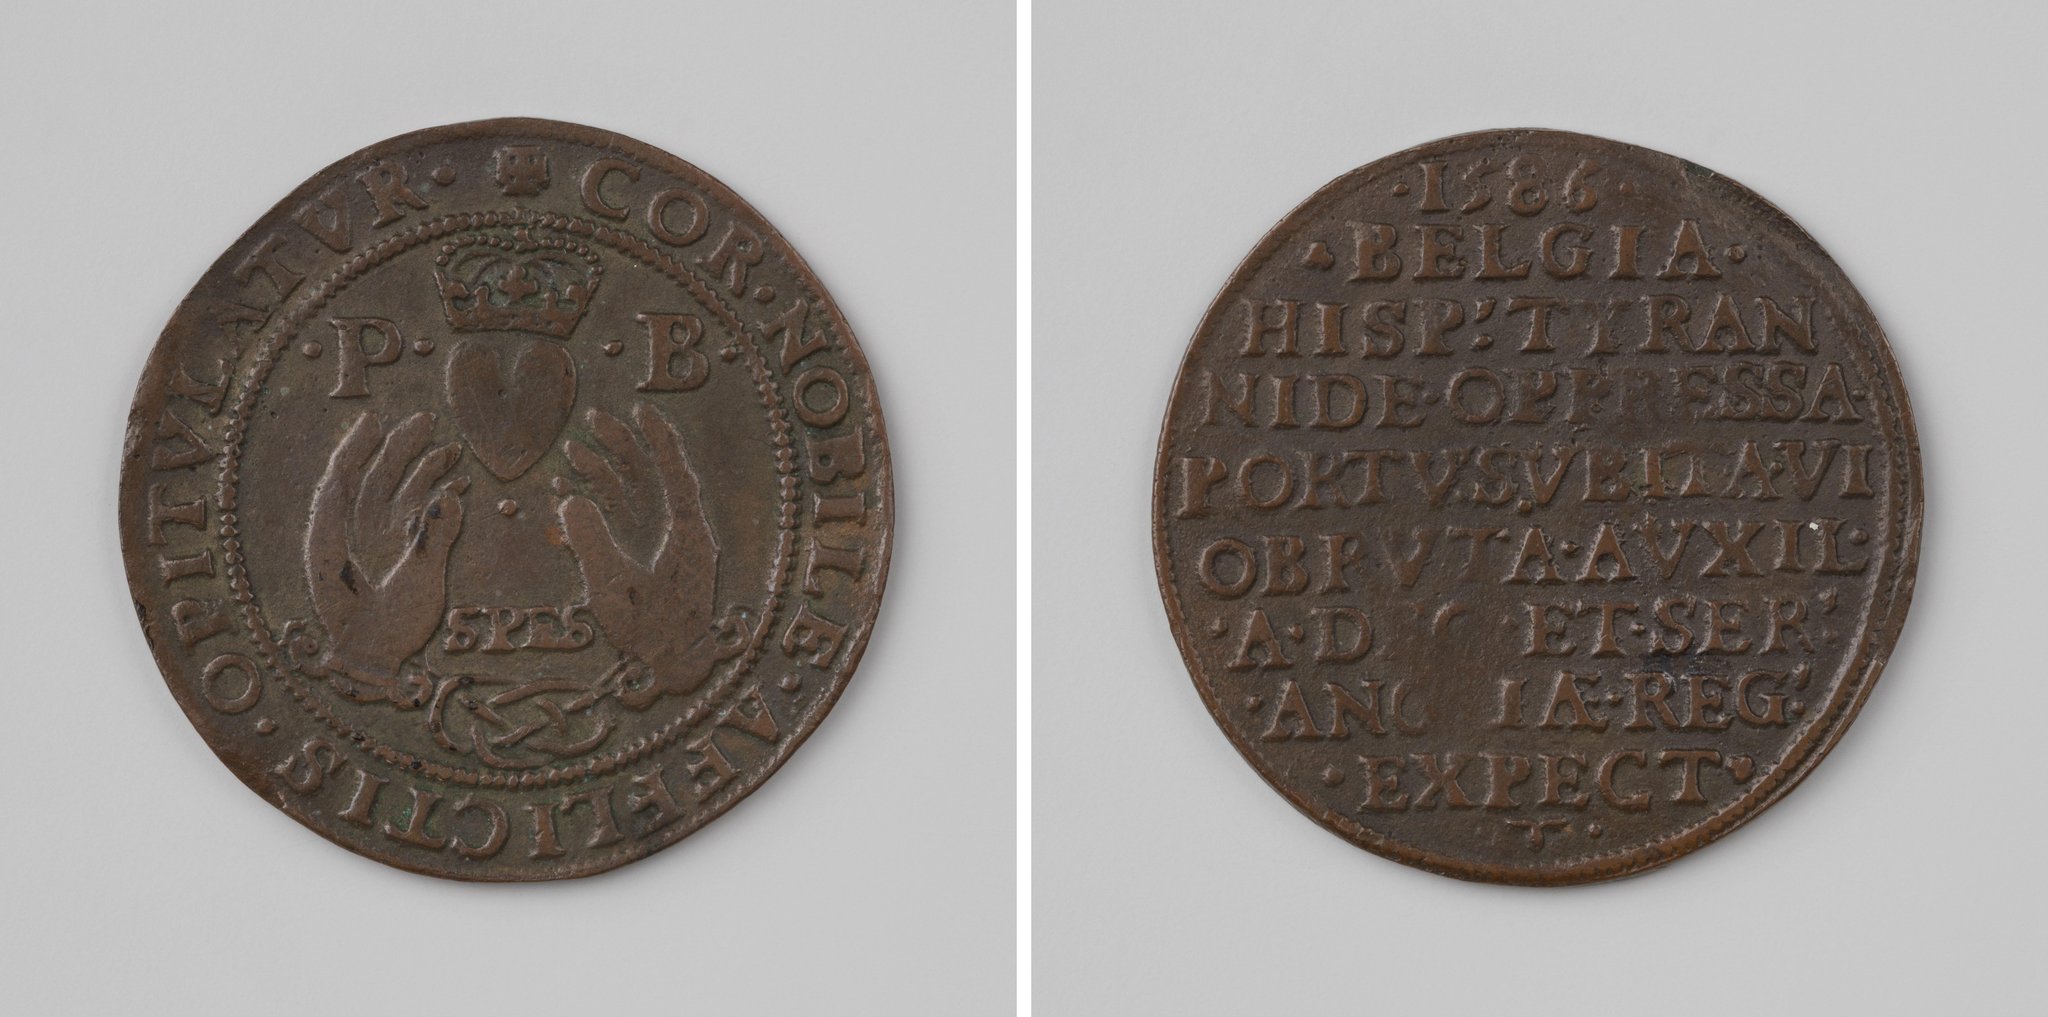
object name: jeton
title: Engelse hulp aan de opstandelingen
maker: Anonymous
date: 1586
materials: copper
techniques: striking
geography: harderwijk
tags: greenwich, koningin, elizabeth i tudor (koningin van engeland), tachtigjarige oorlog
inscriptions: circumscription: ‘COR NOBILE AFFLICTIS OPITVLATVR / P B SPES’, inscription: ‘1586 BELGIA HISP TYRANNIDE OPRESSA PORTV SVBITA VI OBRVTA AVXIL A DEO ET SER ANGLIAE REG EXPECT’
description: Koperen penning. Voorzijde: twee geboeide handen, reikend naar gekroond hart, geflankeerd door letters P en B binnen omschrift. Keerzijde: opschrift.